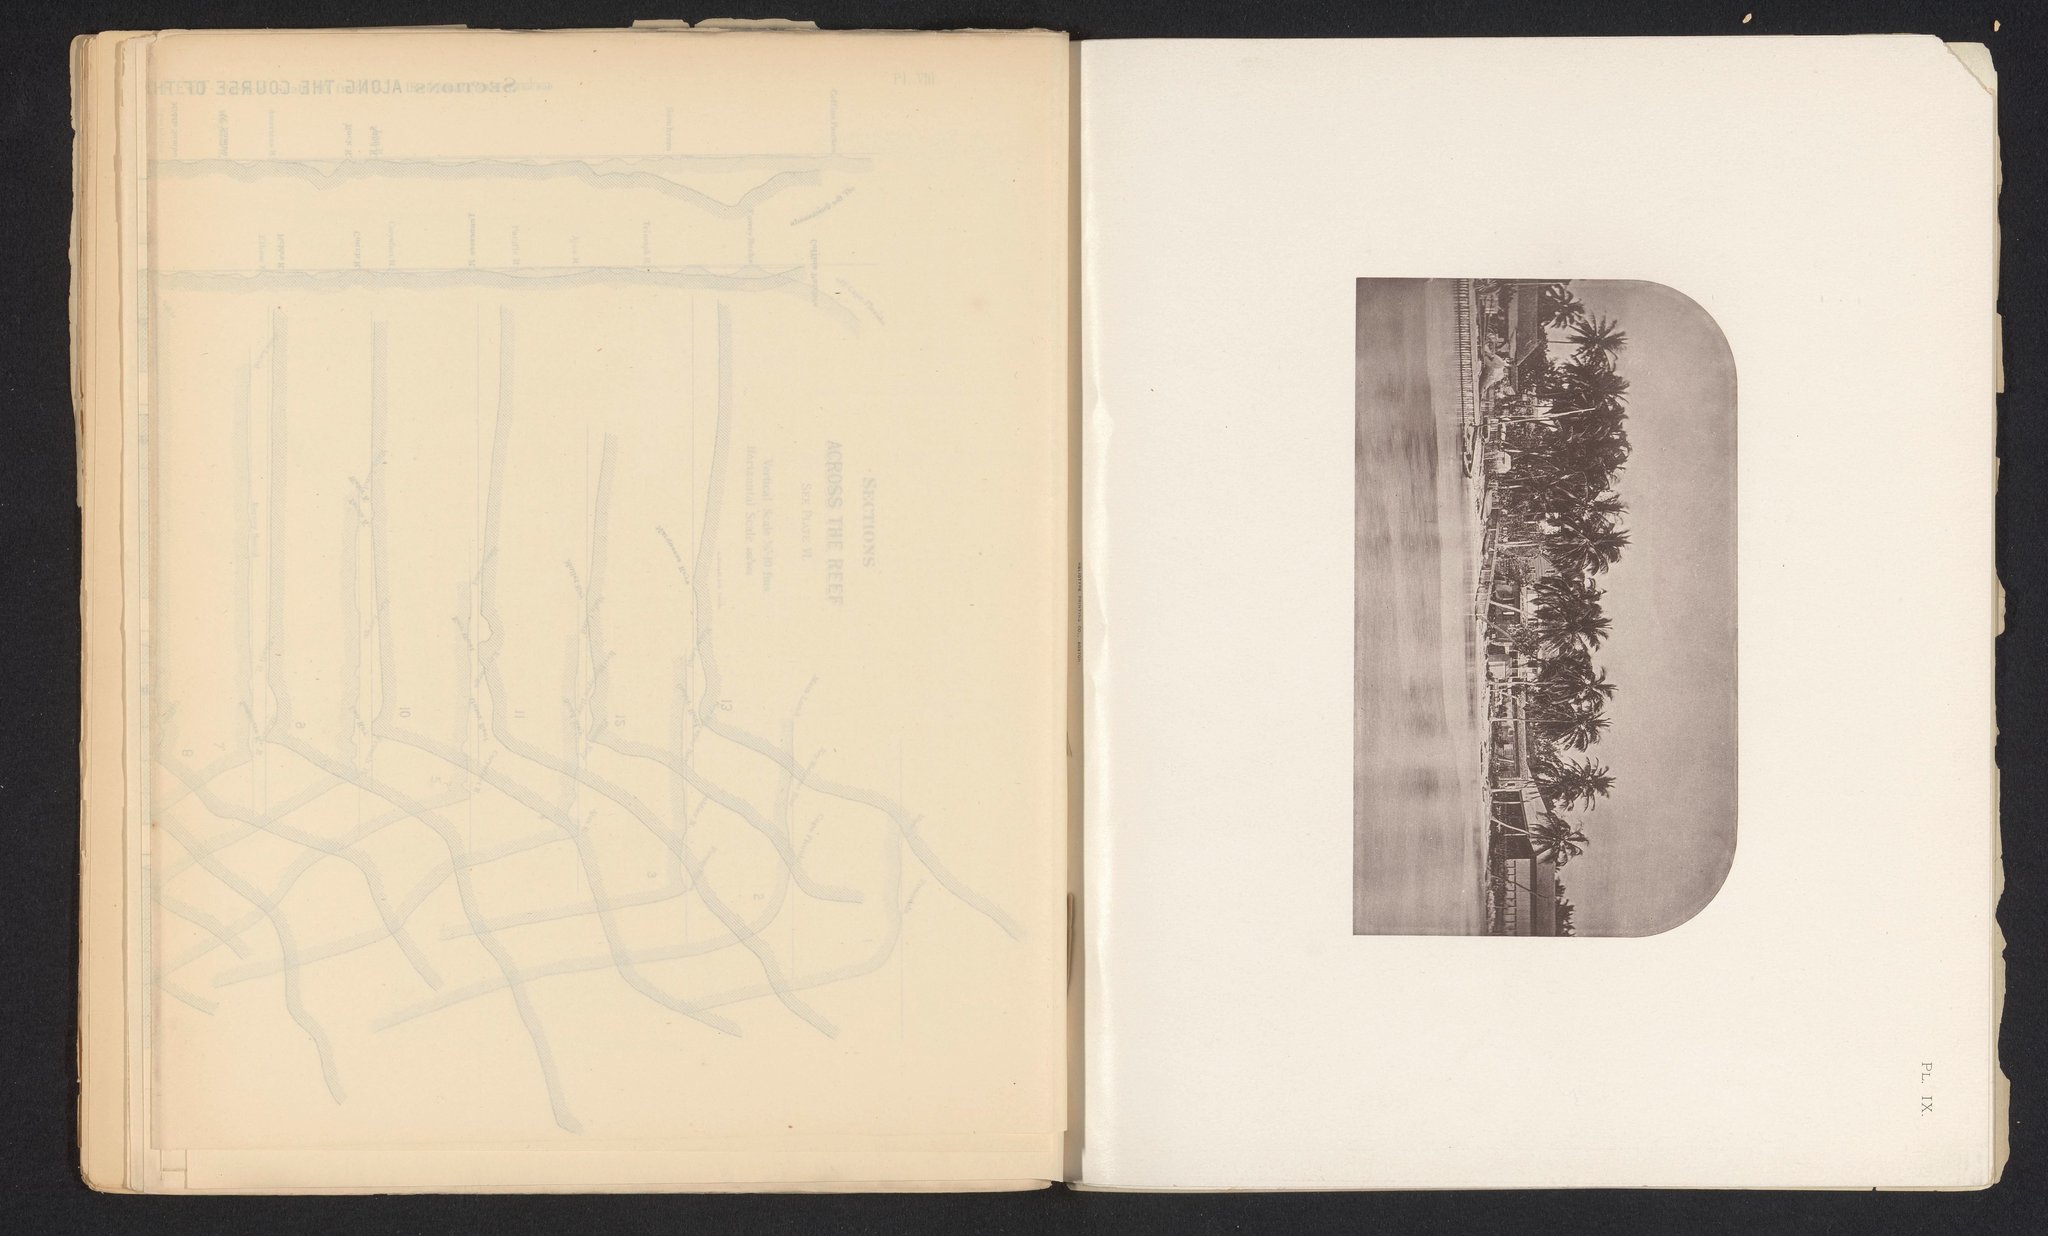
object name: page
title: Gezicht op een strand van Key West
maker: Anonymous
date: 1875-1885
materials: paper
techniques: photograph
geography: florida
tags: trees: palm-tree, beach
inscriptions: number: ‘Pl. IX.’